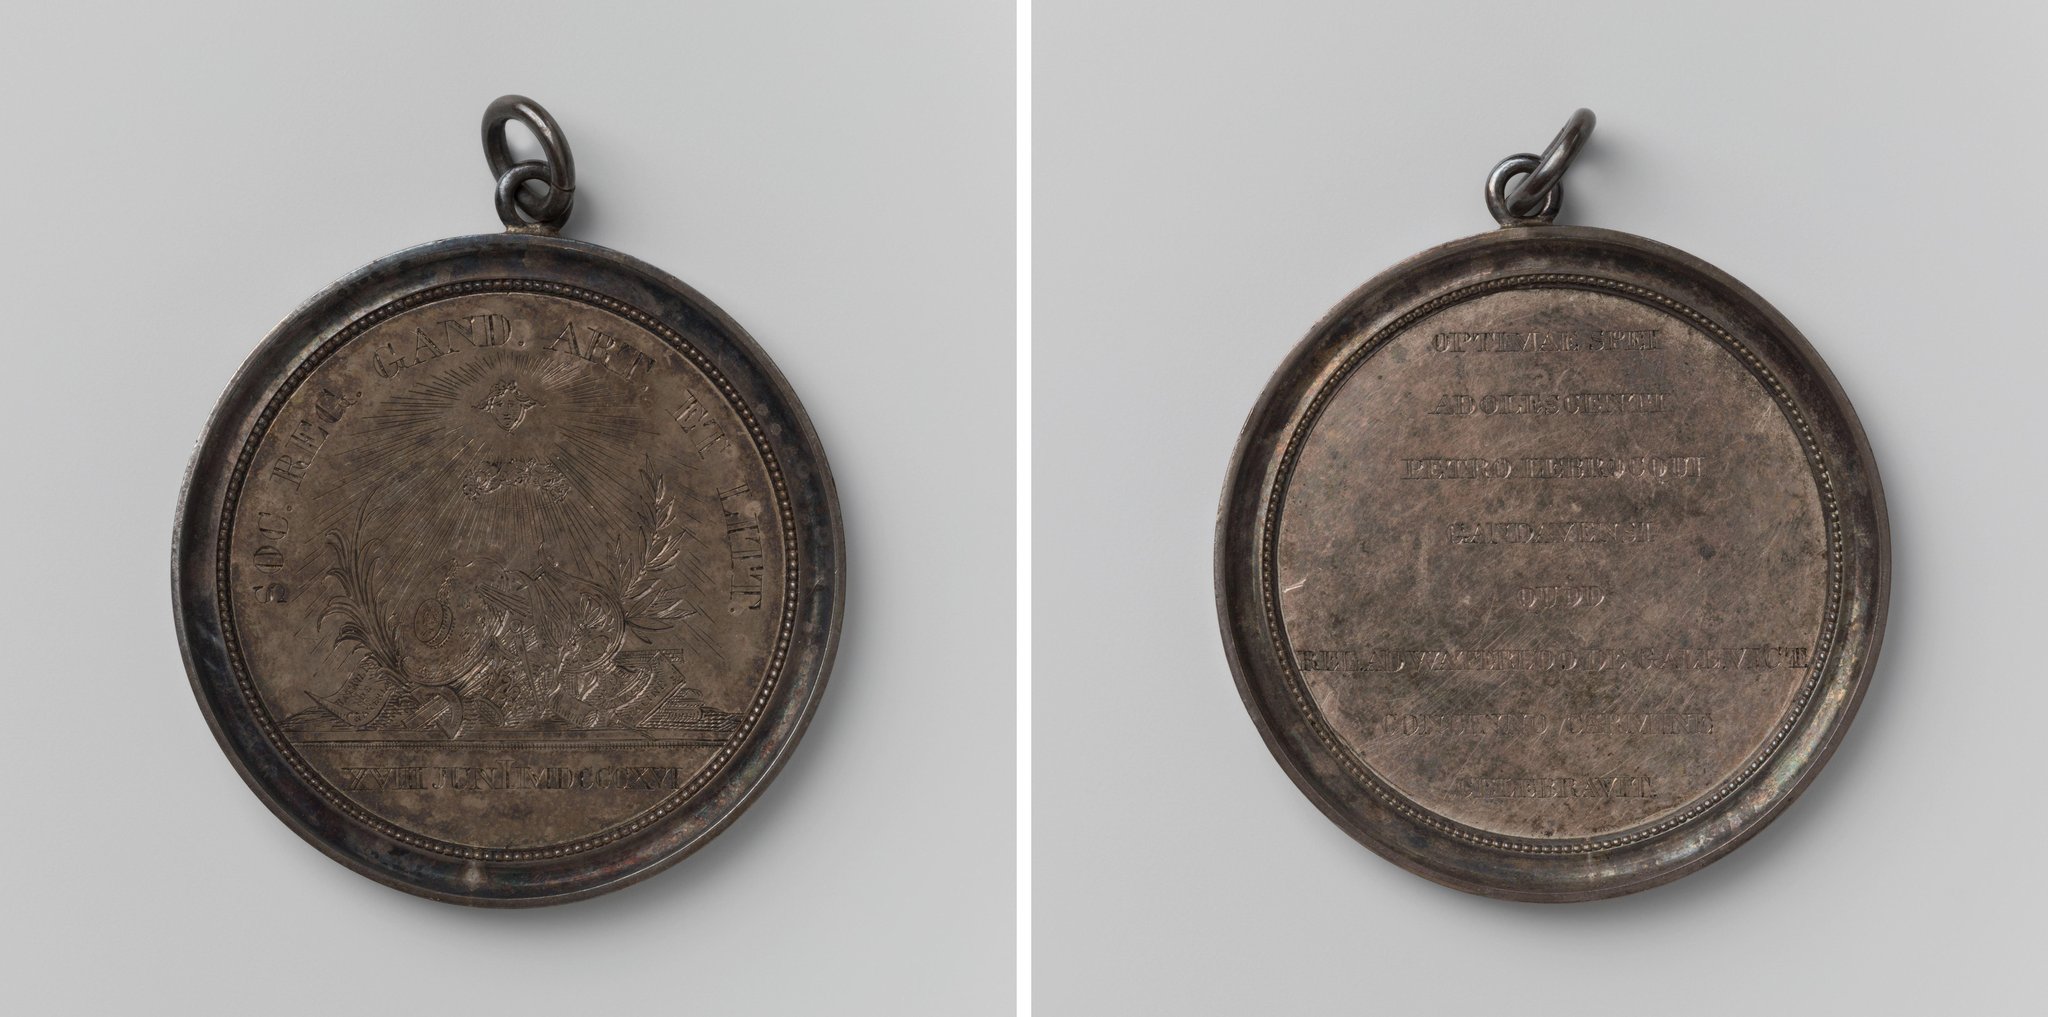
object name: medal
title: Koninklijke Maatschappij van Kunsten en Letteren te Gent, penning uitgereikt aan Peter Lebrocq, wegens zijn werk over de slag bij Waterloo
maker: Anonymous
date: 1816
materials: silver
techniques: engraving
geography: belgium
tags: waterloo, ghent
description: Zilveren penning aan draagoog en draagring. Voorzijde: beschreven vel papier, palmtak, schilderspalet met penselen, waaraan portretmedaillon hangt, graadboog, maatstok, passer, kapiteel, lier, hamer, lauwertak, boeken en graveernaald onder bloemenkrans, beschenen door hoofd in stralenkrans binnen omschrift; afsnede: datering. Keerzijde: opschrift